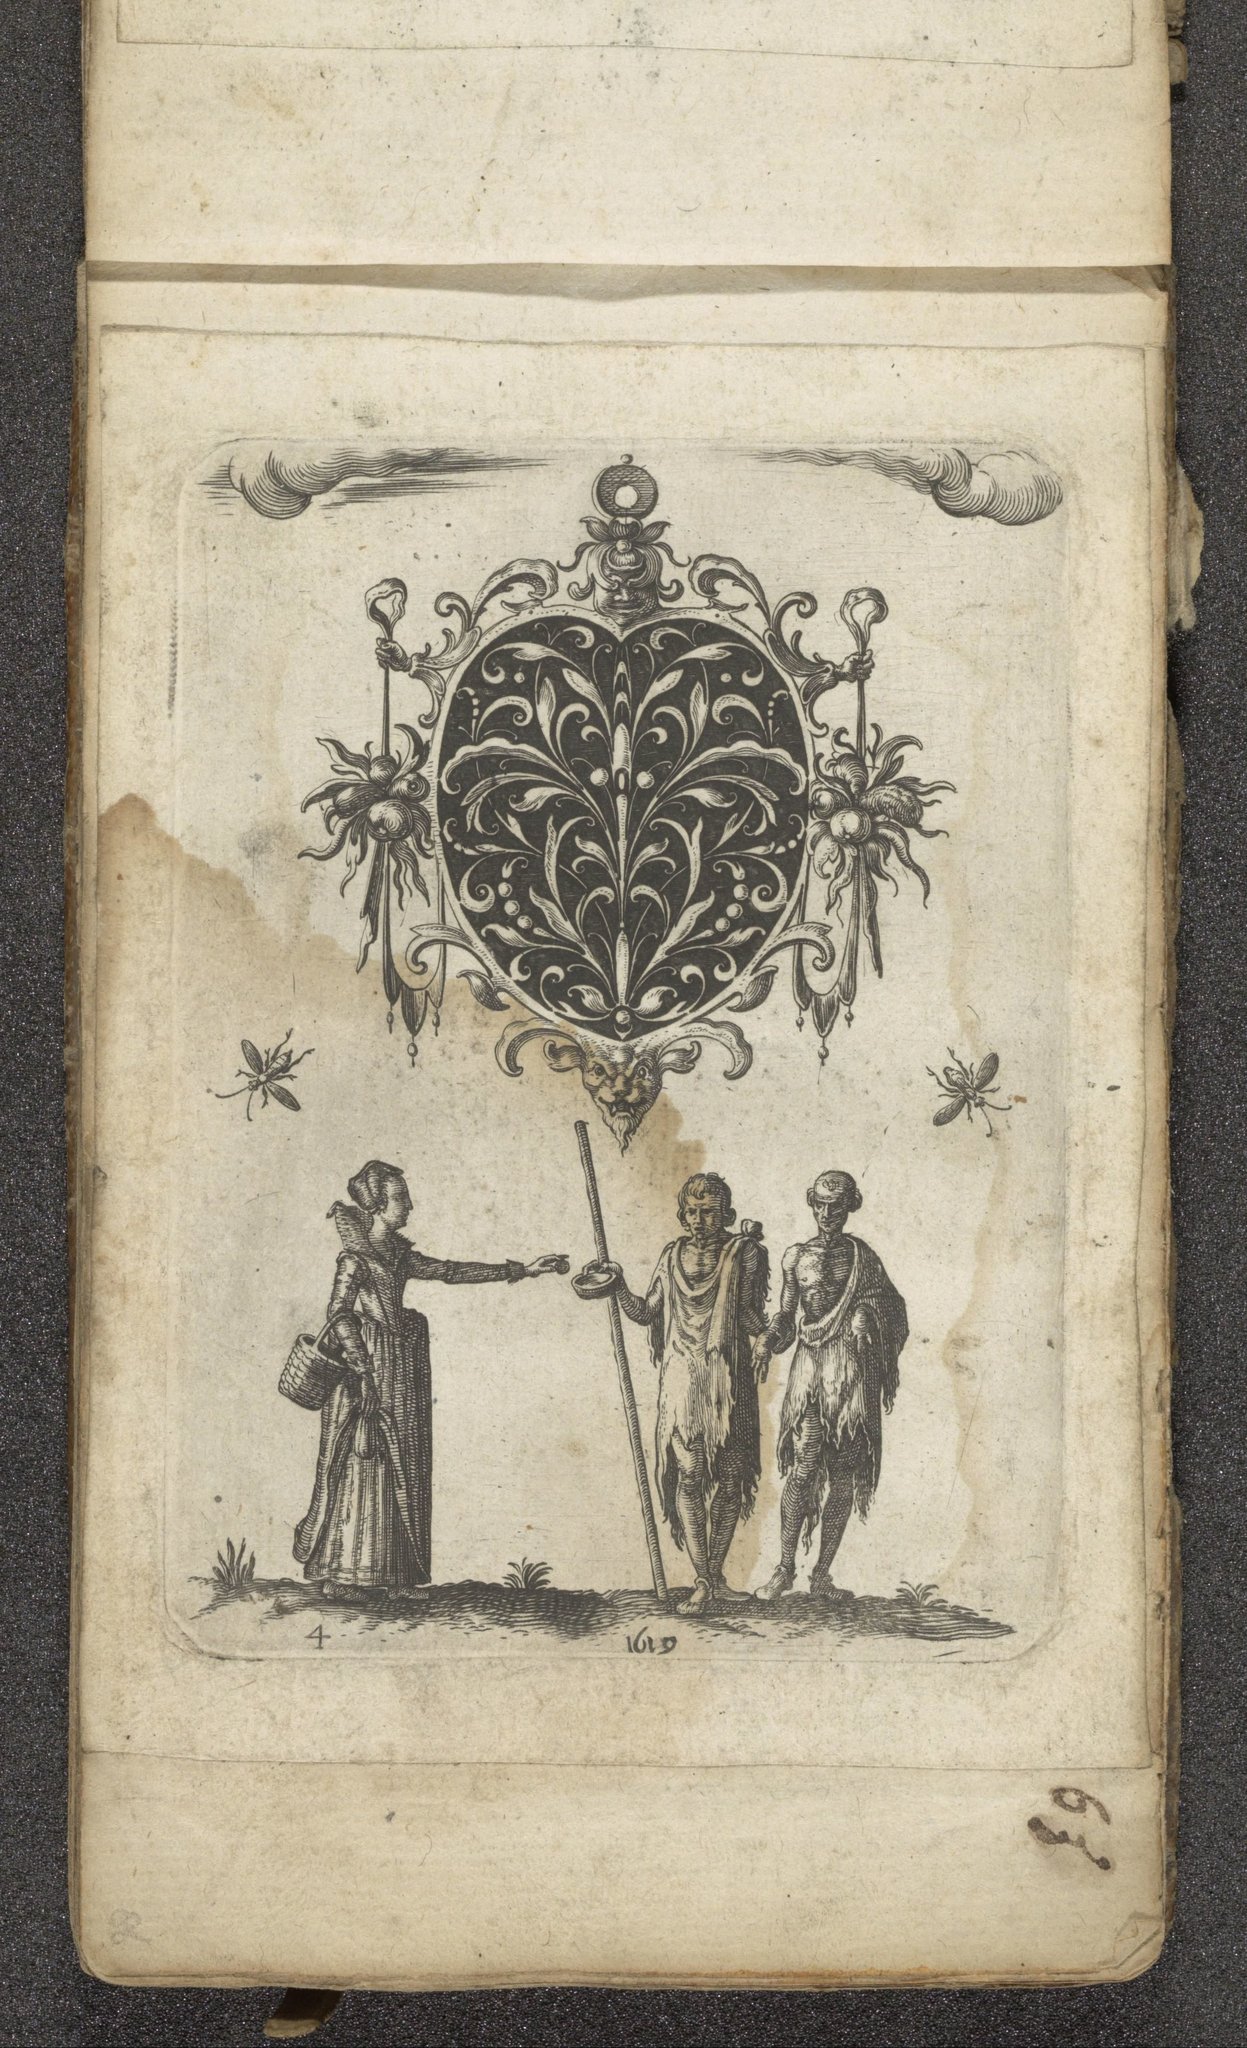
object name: album leaf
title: Blackwork in the Shape of a Heart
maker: jean toutin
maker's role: print maker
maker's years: 1578-1644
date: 1619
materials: paper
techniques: engraving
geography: châteaudun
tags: ornaments ~ art, the rich, insects: bee, giving alms; collection, the poor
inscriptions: inscription: ‘65’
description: Pasted into this sketchbook are 131 French, German, and Flemish ornament prints and biblical depictions, including a series of blackwork ornaments by the enameller Jean Toutin. This page presents the back of a heart-shaped medallion with a floral pattern as inspiration for an engraver or enamel worker. Under the eye is a small figure with hands holding bunches of fruit on either side.